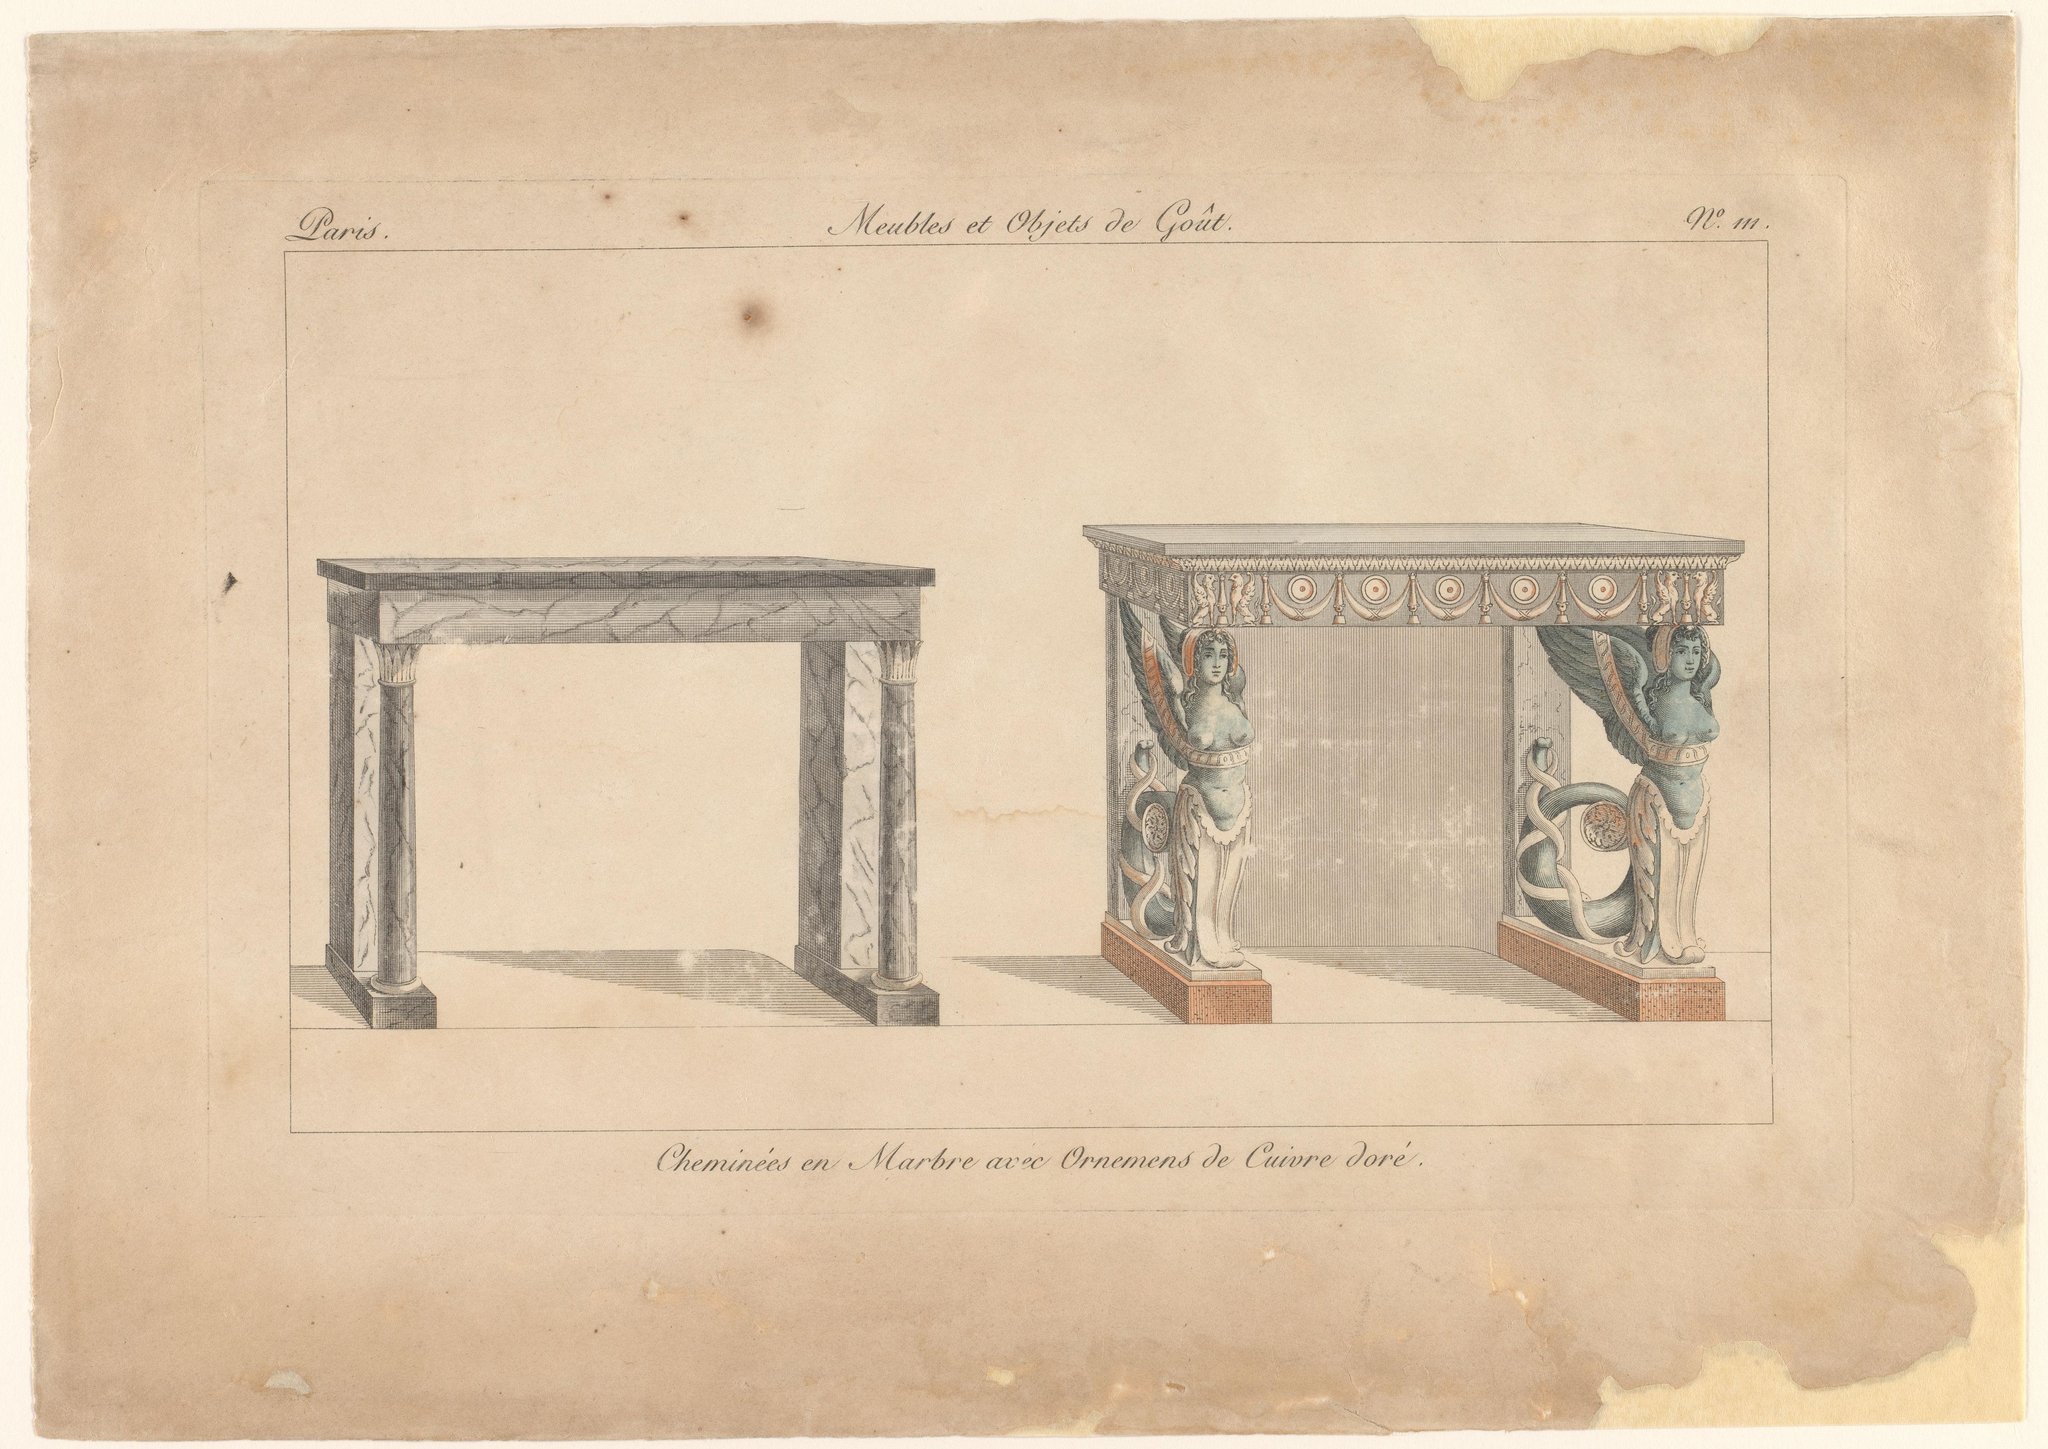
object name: print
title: Meubles et Objets de Goût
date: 1801-1831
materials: paper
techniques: engraving, hand coloring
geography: paris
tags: open hearth, fire-place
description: Ontwerpen van twee schoorsteenmantels van marmer, rechts met sfinxen. Prentnummer 111.